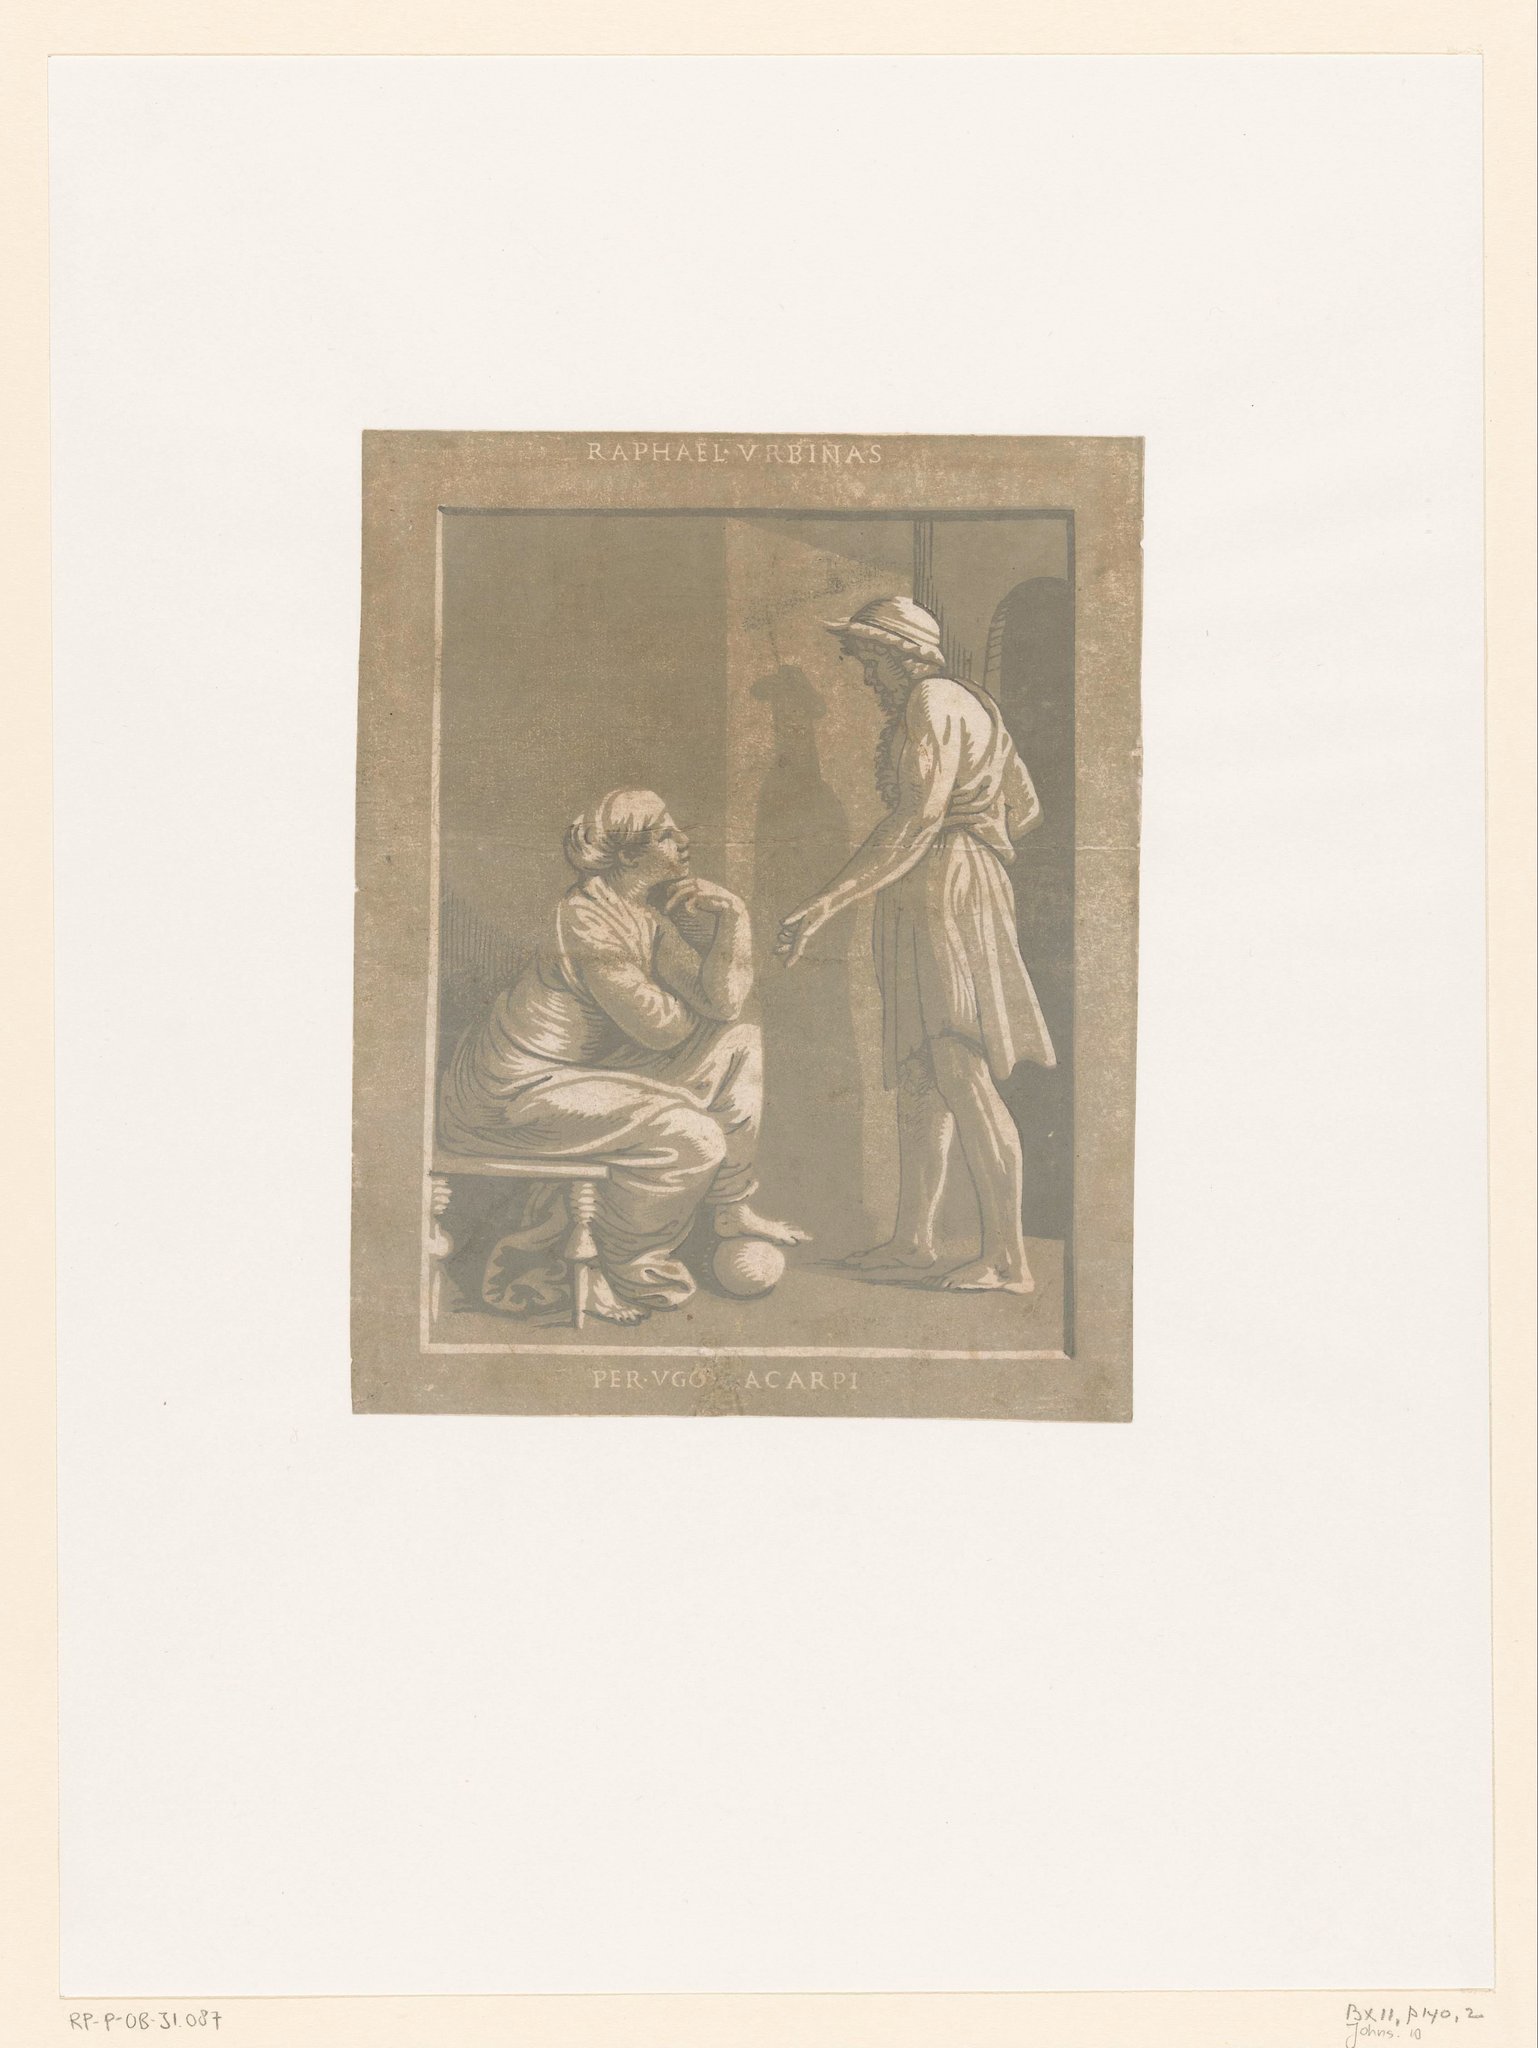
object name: print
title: Staande man en zittende vrouw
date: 1502-1532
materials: paper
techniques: woodcut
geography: italy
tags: rome, painter, rafaël, historical persons, mistress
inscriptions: collector's mark: Lugt 240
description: Rechts staat een man met een hoed. Links zit een vrouw met haar voet op een bol. Mogelijk de kunstenaar Rafaël en zijn maîtresse.